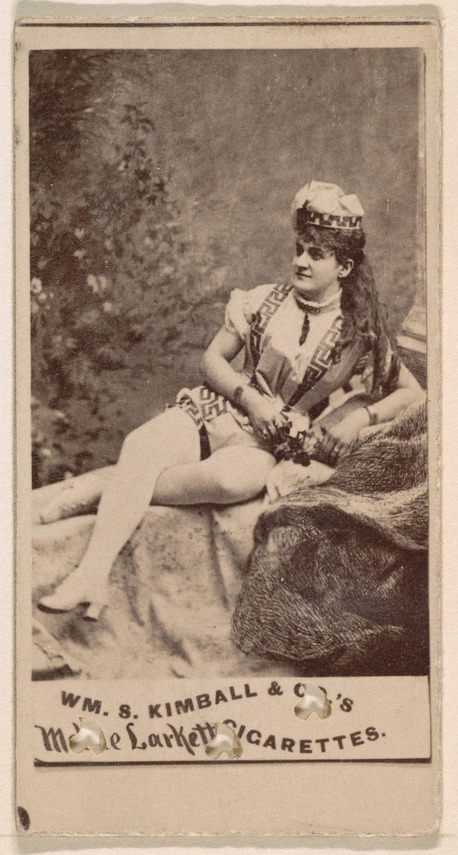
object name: photograph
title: Miss Larkett, from the Actresses series (N203) issued by Wm. S. Kimball & Co.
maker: william s. kimball & company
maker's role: publisher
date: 1889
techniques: color lithograph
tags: portraits,women,actresses